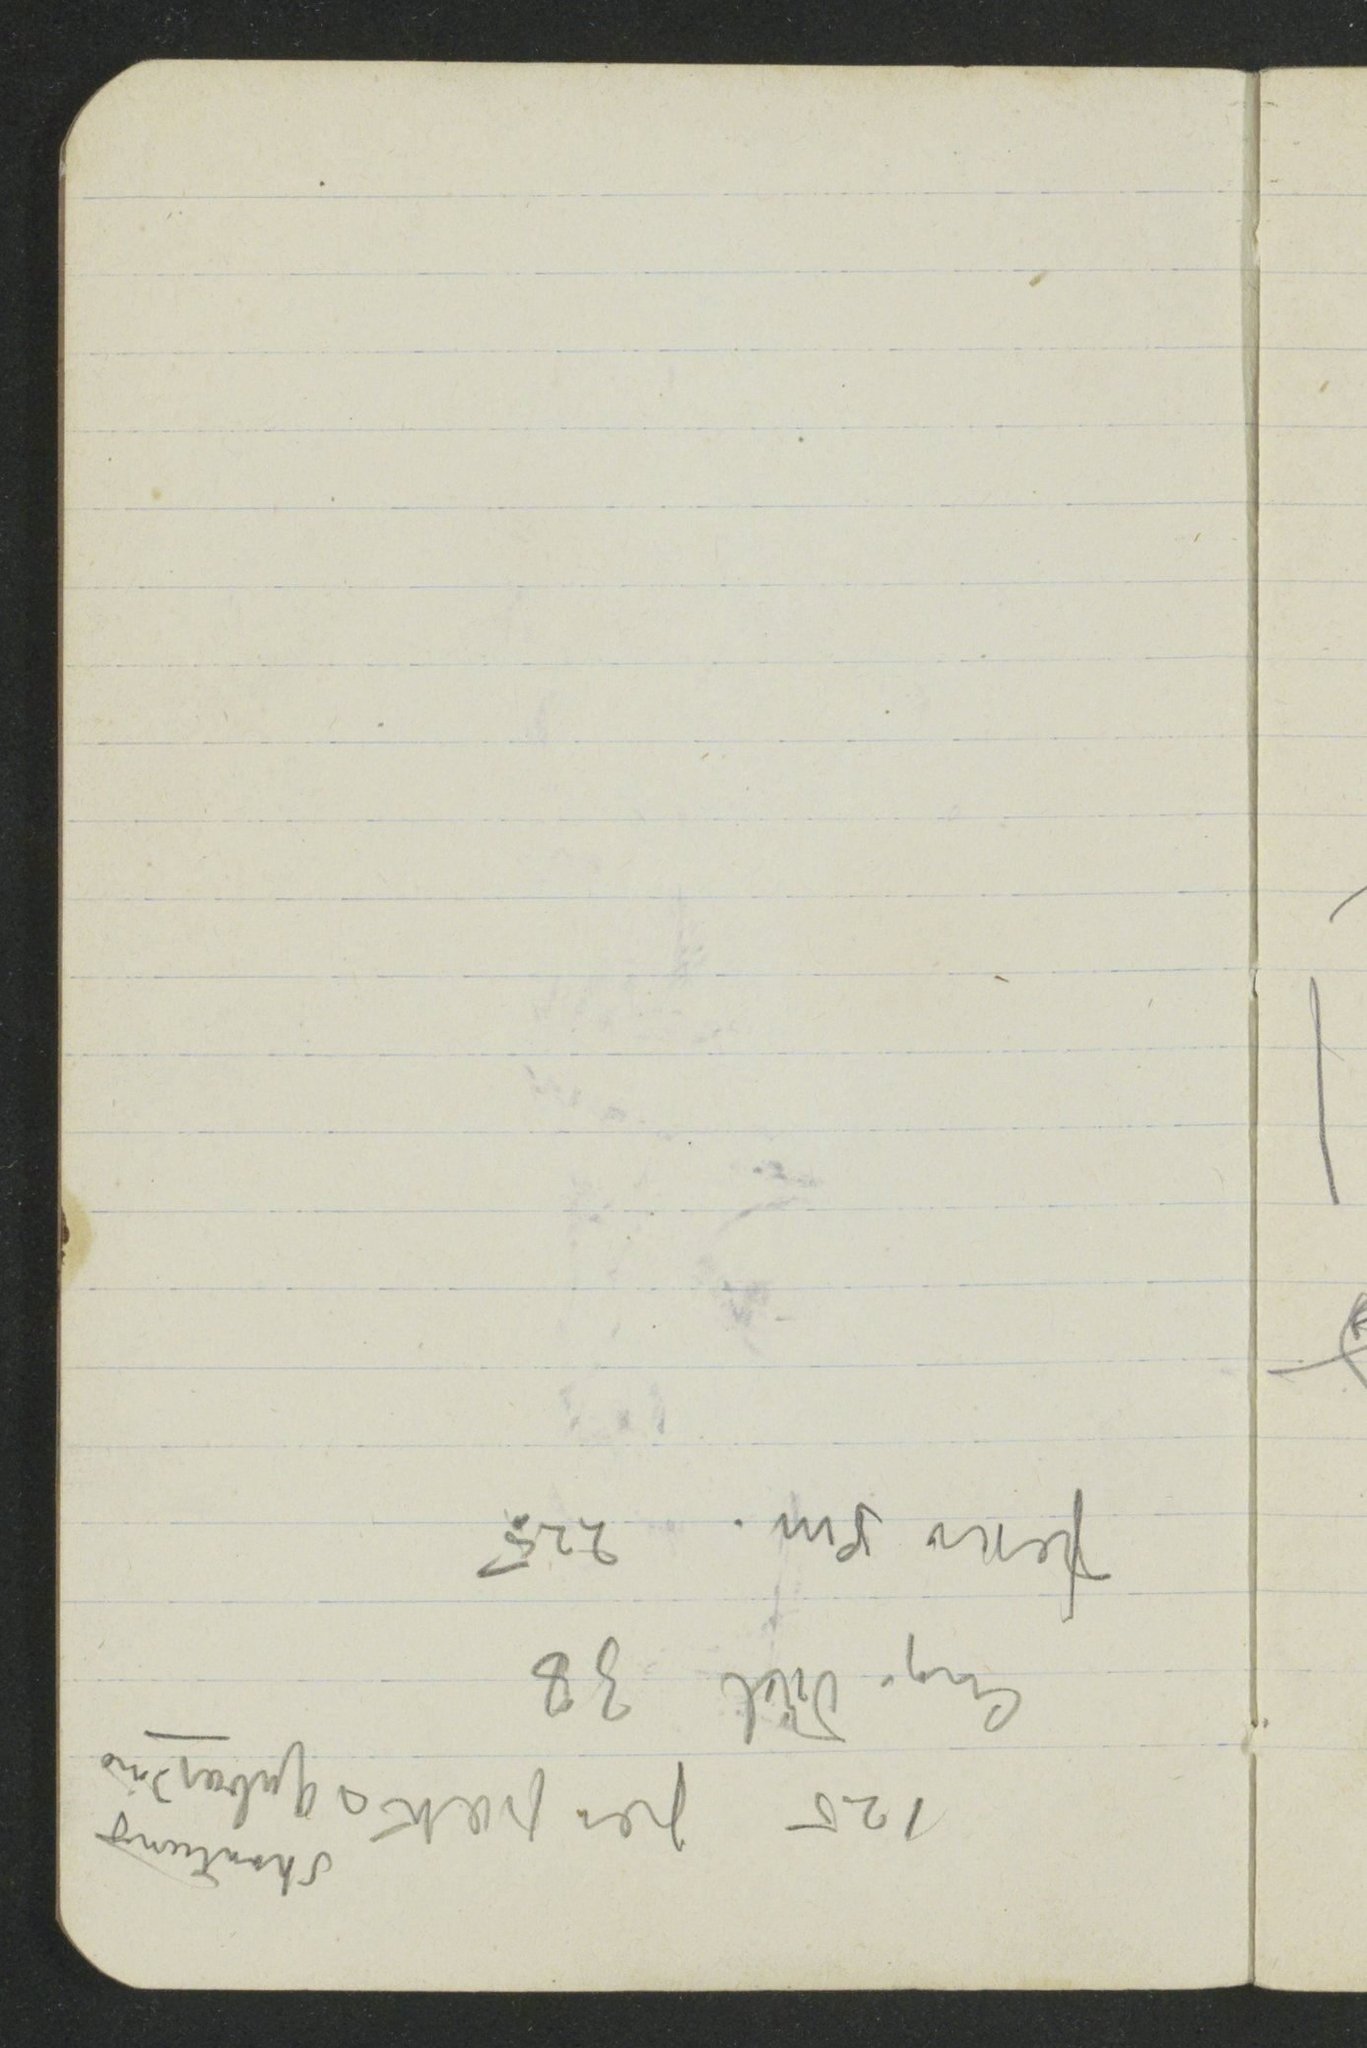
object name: sketchbook leaf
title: Annotaties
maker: isaac israels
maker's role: draughtsman, painter, print maker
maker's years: 1865-1934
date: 1875-1934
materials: pencil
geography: the hague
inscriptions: annotation: ‘[...]’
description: Pagina 2 uit schetsboek XL met 40 pagina's.